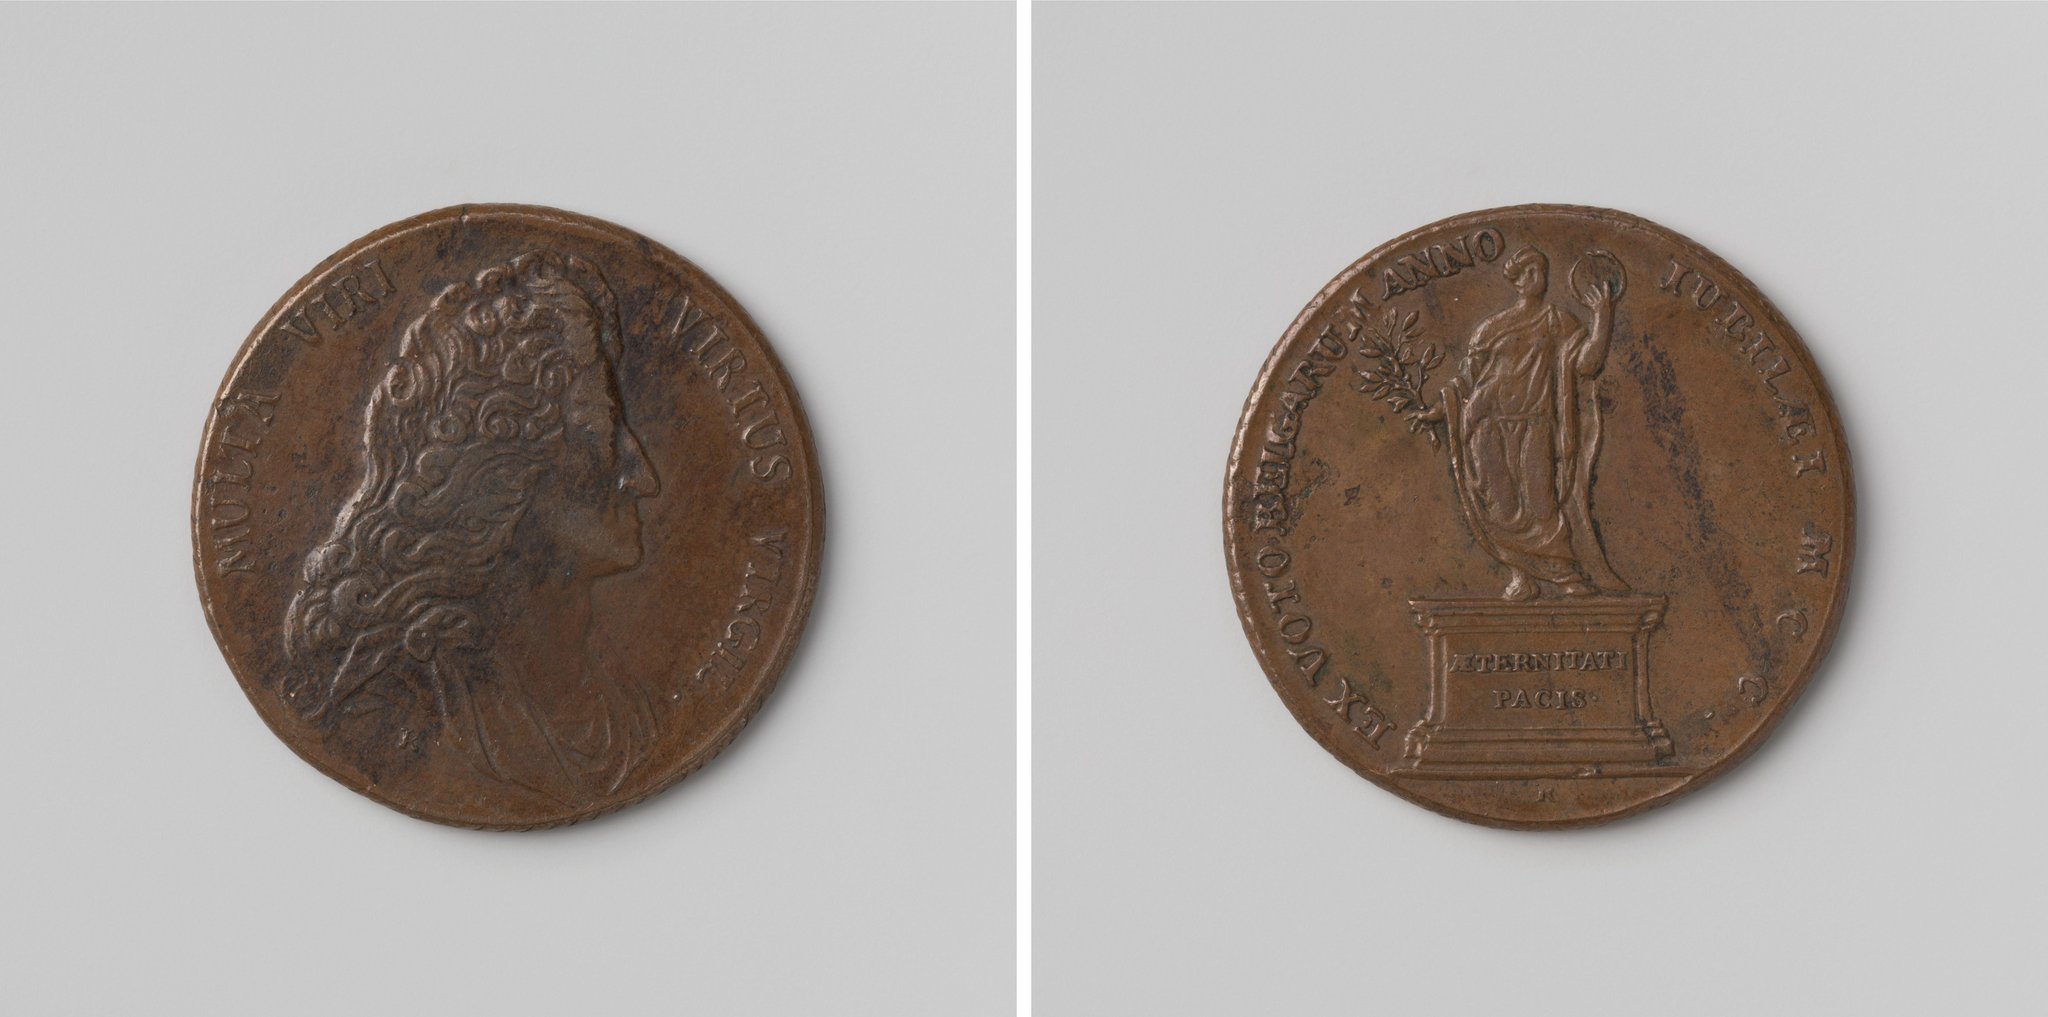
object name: jeton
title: Jubeljaar 1700 en vrede van Rijswijk, rekenpenning geslagen ter ere van Maximiliaan II Emanuel, keurvorst van Beieren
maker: philippe roëttiers (ii)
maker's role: medailleur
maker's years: 1640-1718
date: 1700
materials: copper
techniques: striking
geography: antwerp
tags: maximiliaan ii emanuel (keurvorst van beieren)